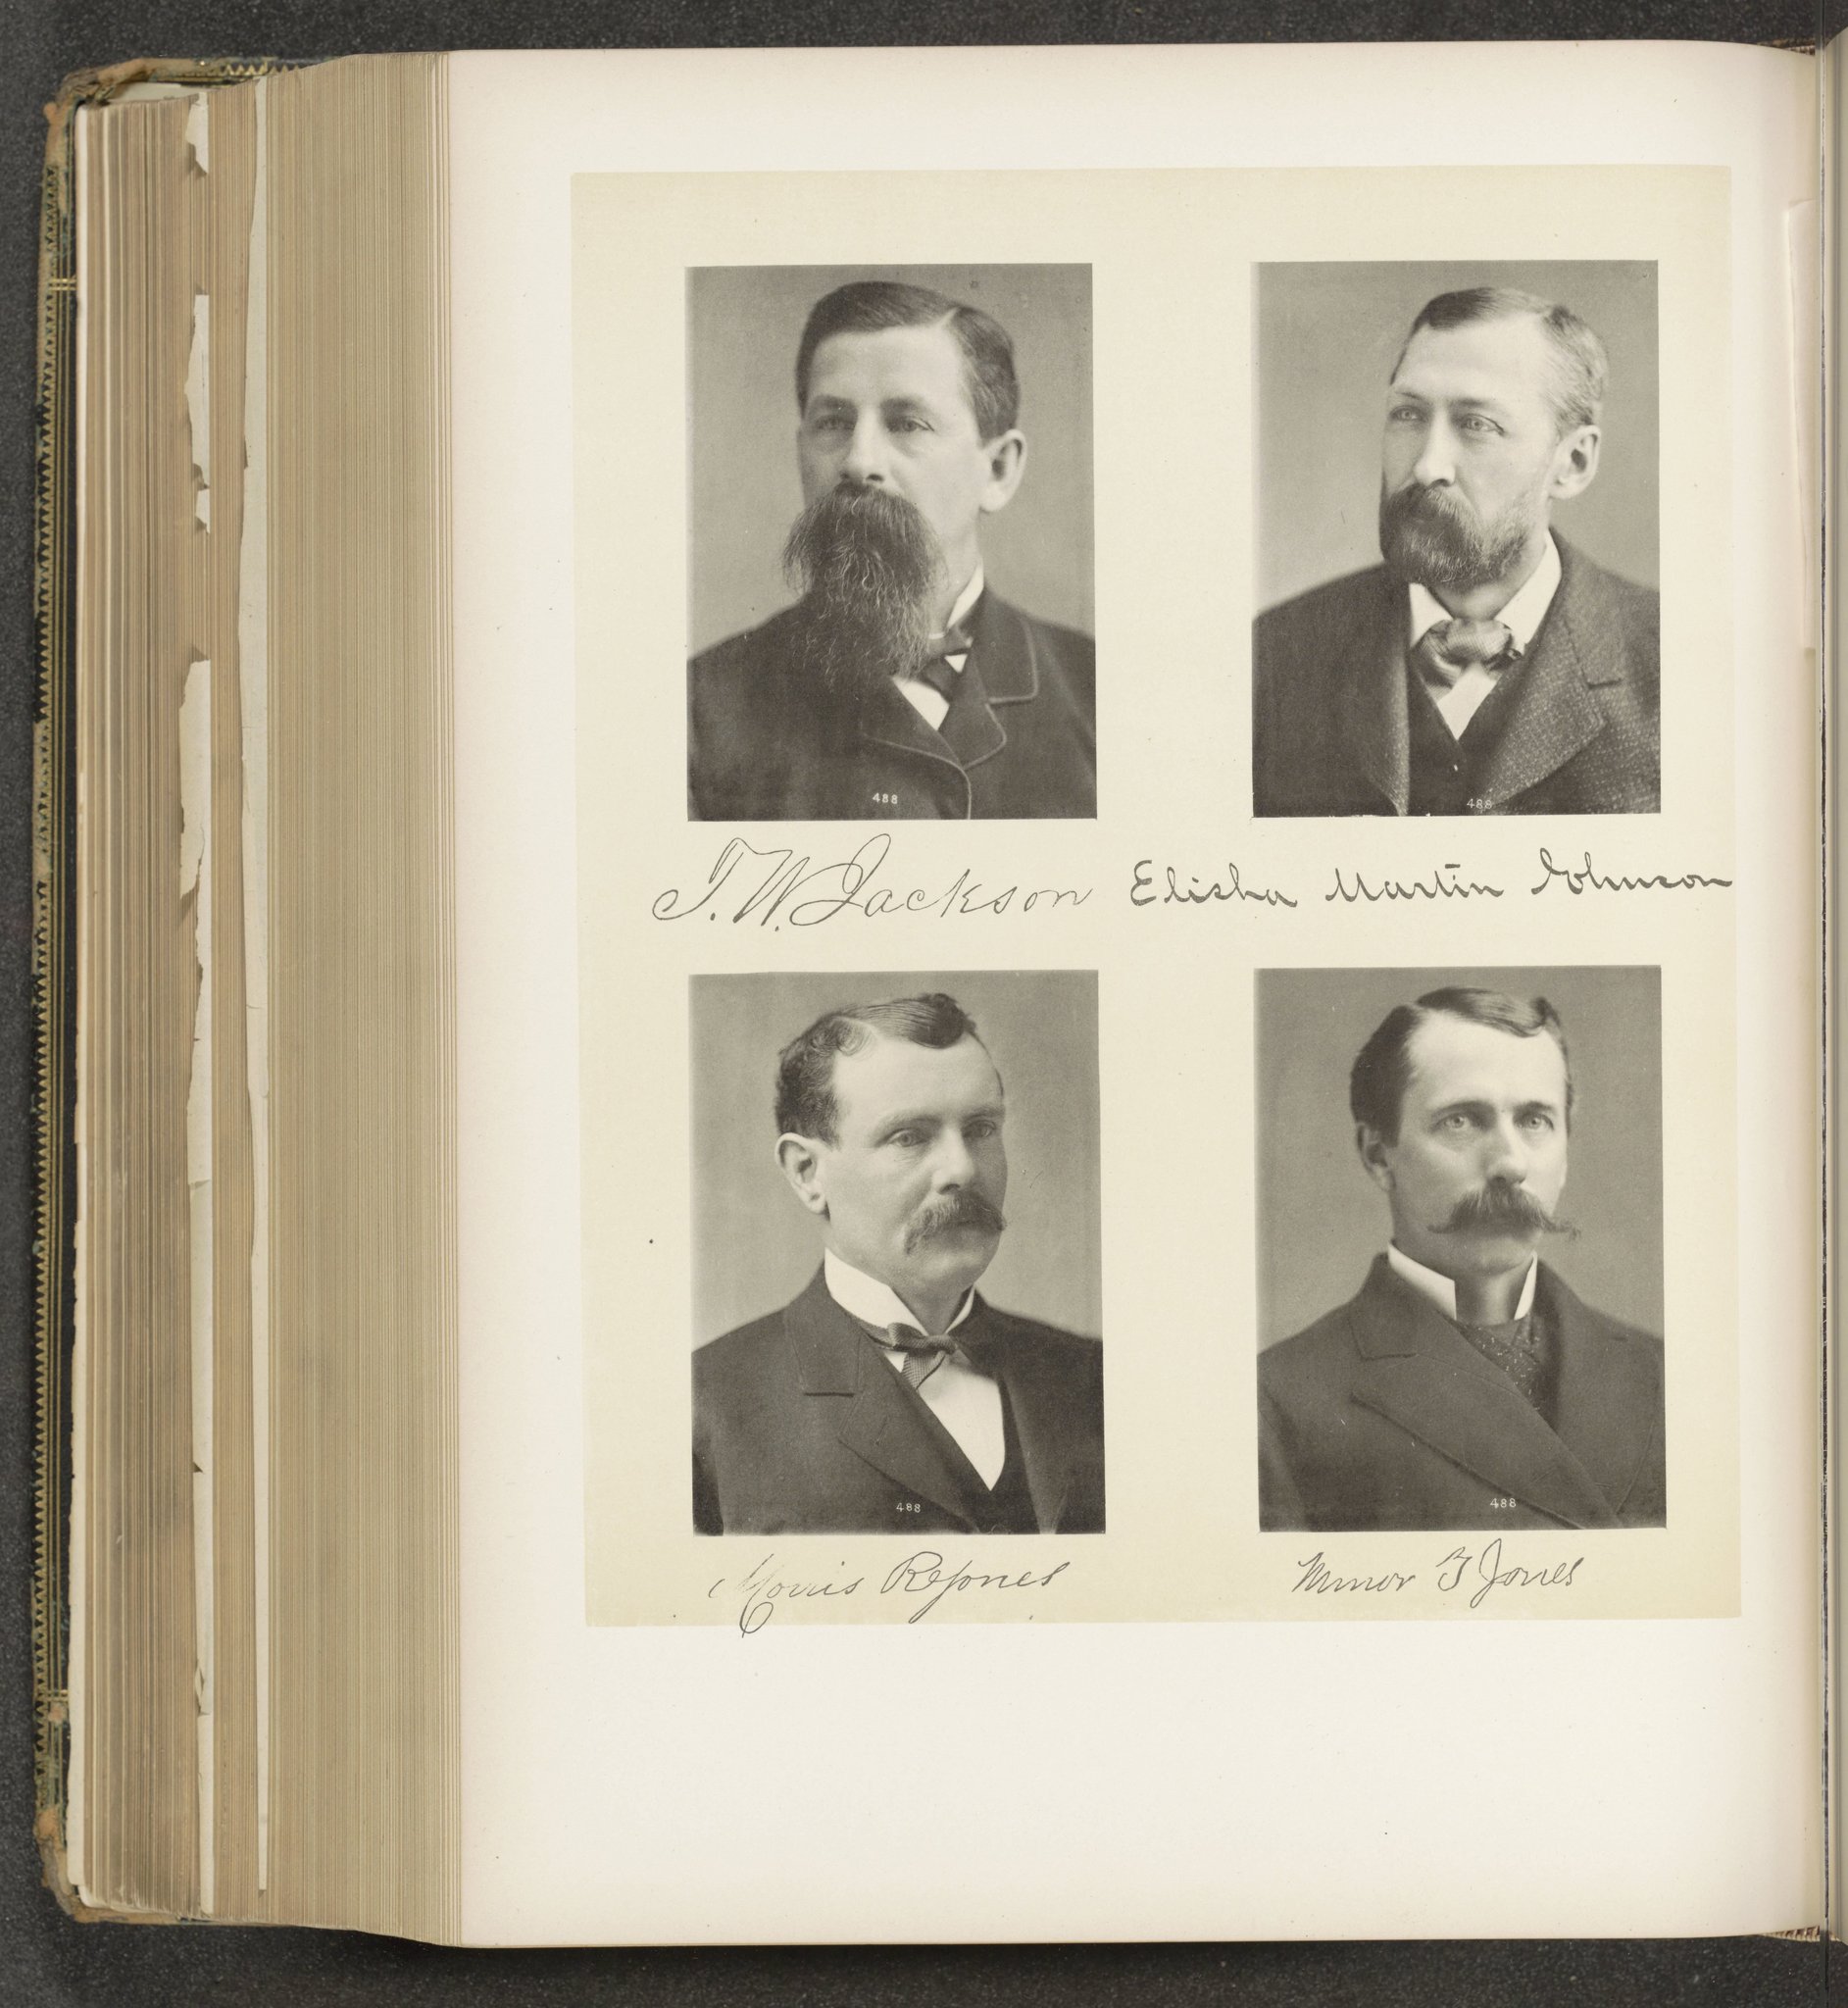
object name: page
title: Portretten van vier leden van het Lagerhuis van de staat New York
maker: Anonymous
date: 1872-1882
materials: paper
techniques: photograph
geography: united states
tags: historical persons (portraits and scenes from the life) (+ head (and shoulders) (portrait))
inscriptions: annotation, number: ‘488’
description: Linksboven Timothy W. Jackson, rechtsboven Elisha Martin Johnson, linksonder Morris R. Jones, rechtsonder Minor T. Jones.